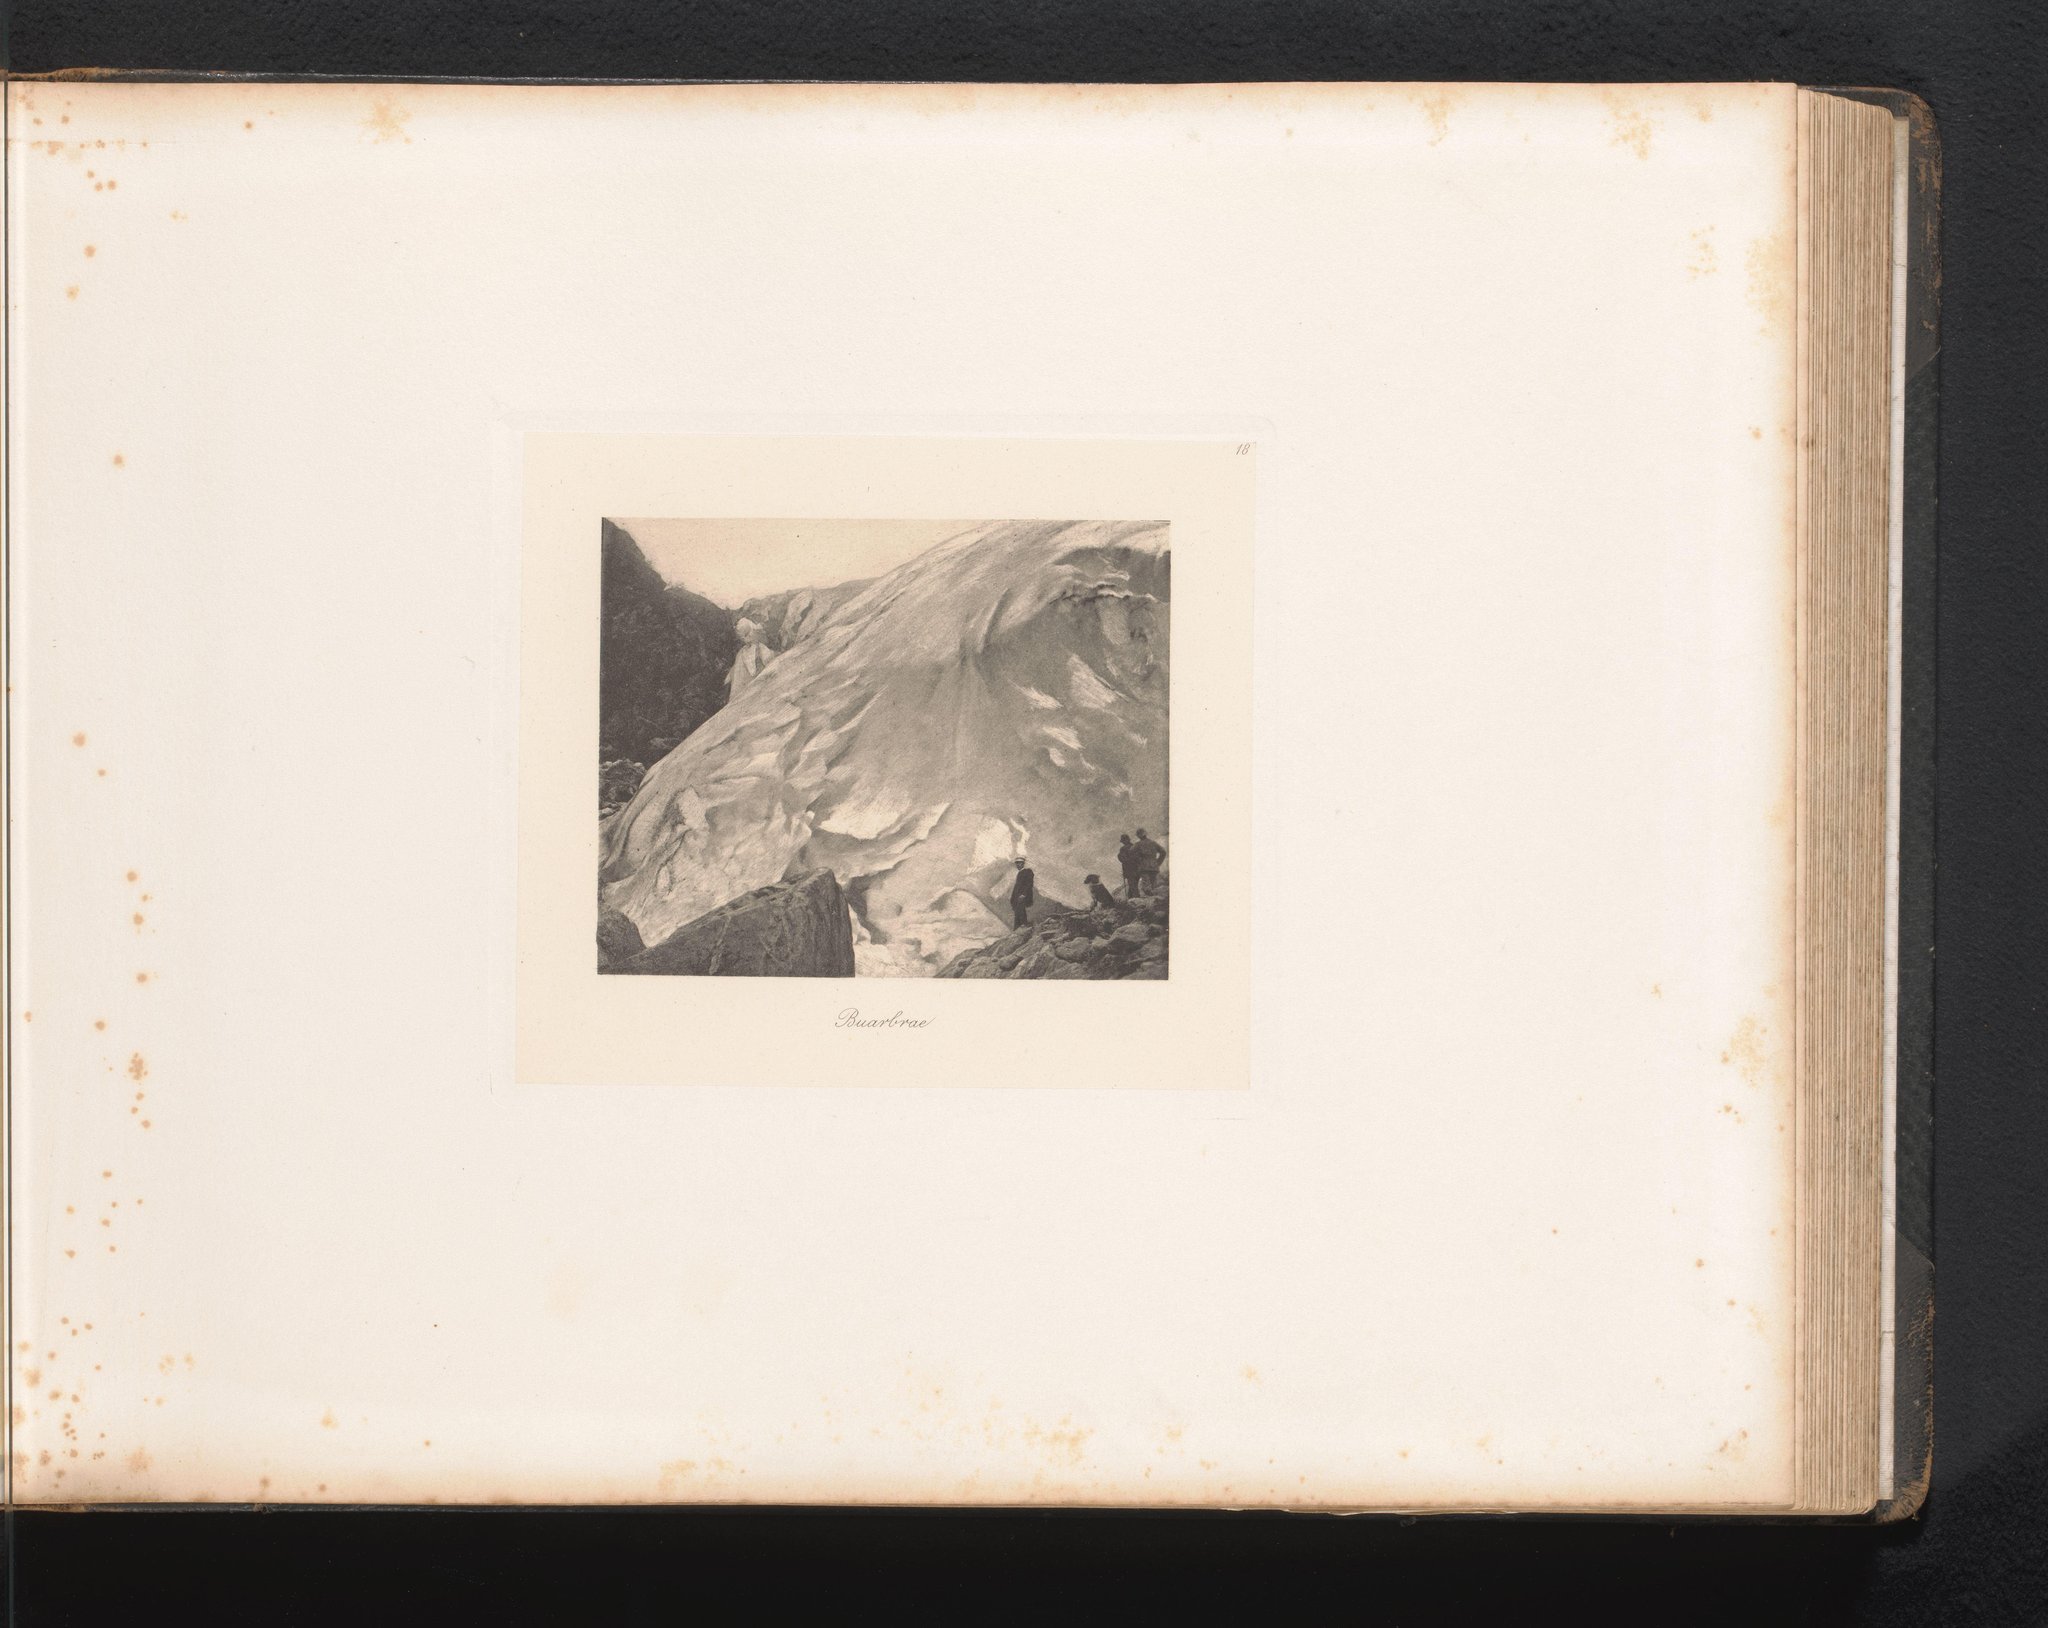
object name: photomechanical print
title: Bergbeklimmers bij de Buerbreen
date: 1888-1893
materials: paper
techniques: photograph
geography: vienna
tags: glacier (+ landscape with figures, staffage)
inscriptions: number: ‘18’